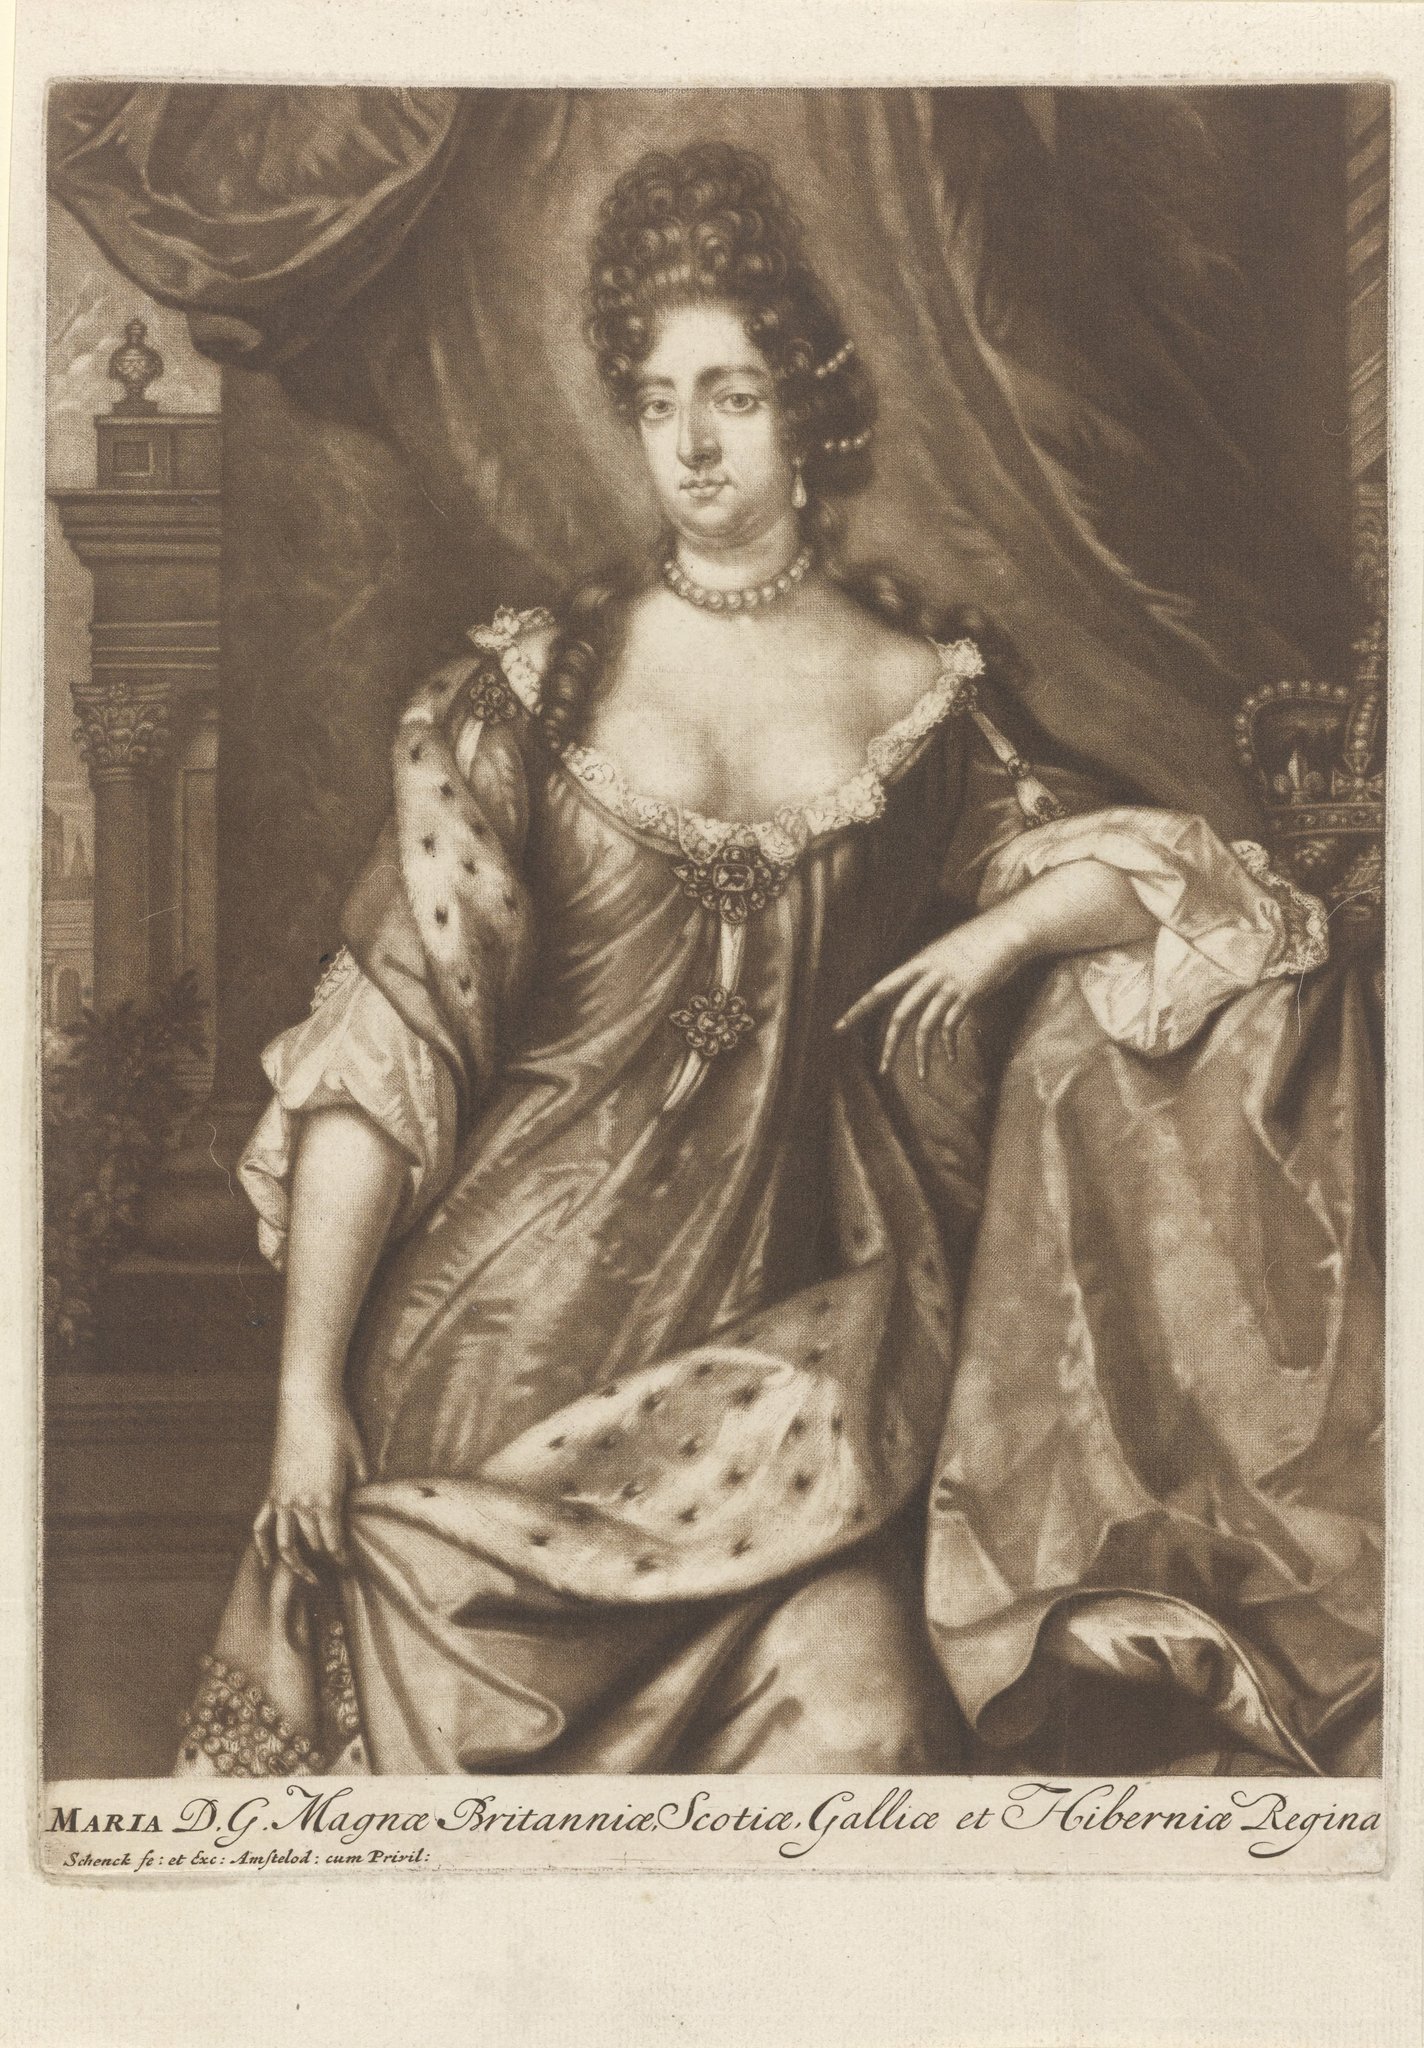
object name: print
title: Portret van Maria II Stuart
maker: pieter schenk (i)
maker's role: print maker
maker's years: 1660-1711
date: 1688-1711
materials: paper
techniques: mezzotint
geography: amsterdam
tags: london, maria ii stuart (koningin van engeland, schotland en ierland)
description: Portret van Maria II. Ze leunt op een tafel met daarop een kroon. In de ondermarge haar naam en titels.